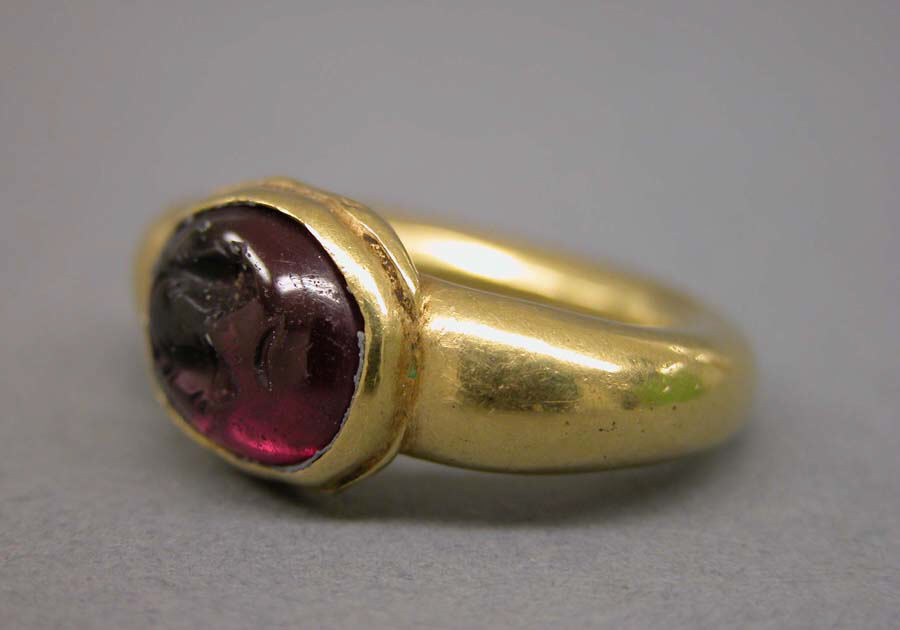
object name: ring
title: Ring with Dark Red Inset Oval-Shaped Stone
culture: indonesian, javanese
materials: gold, stone